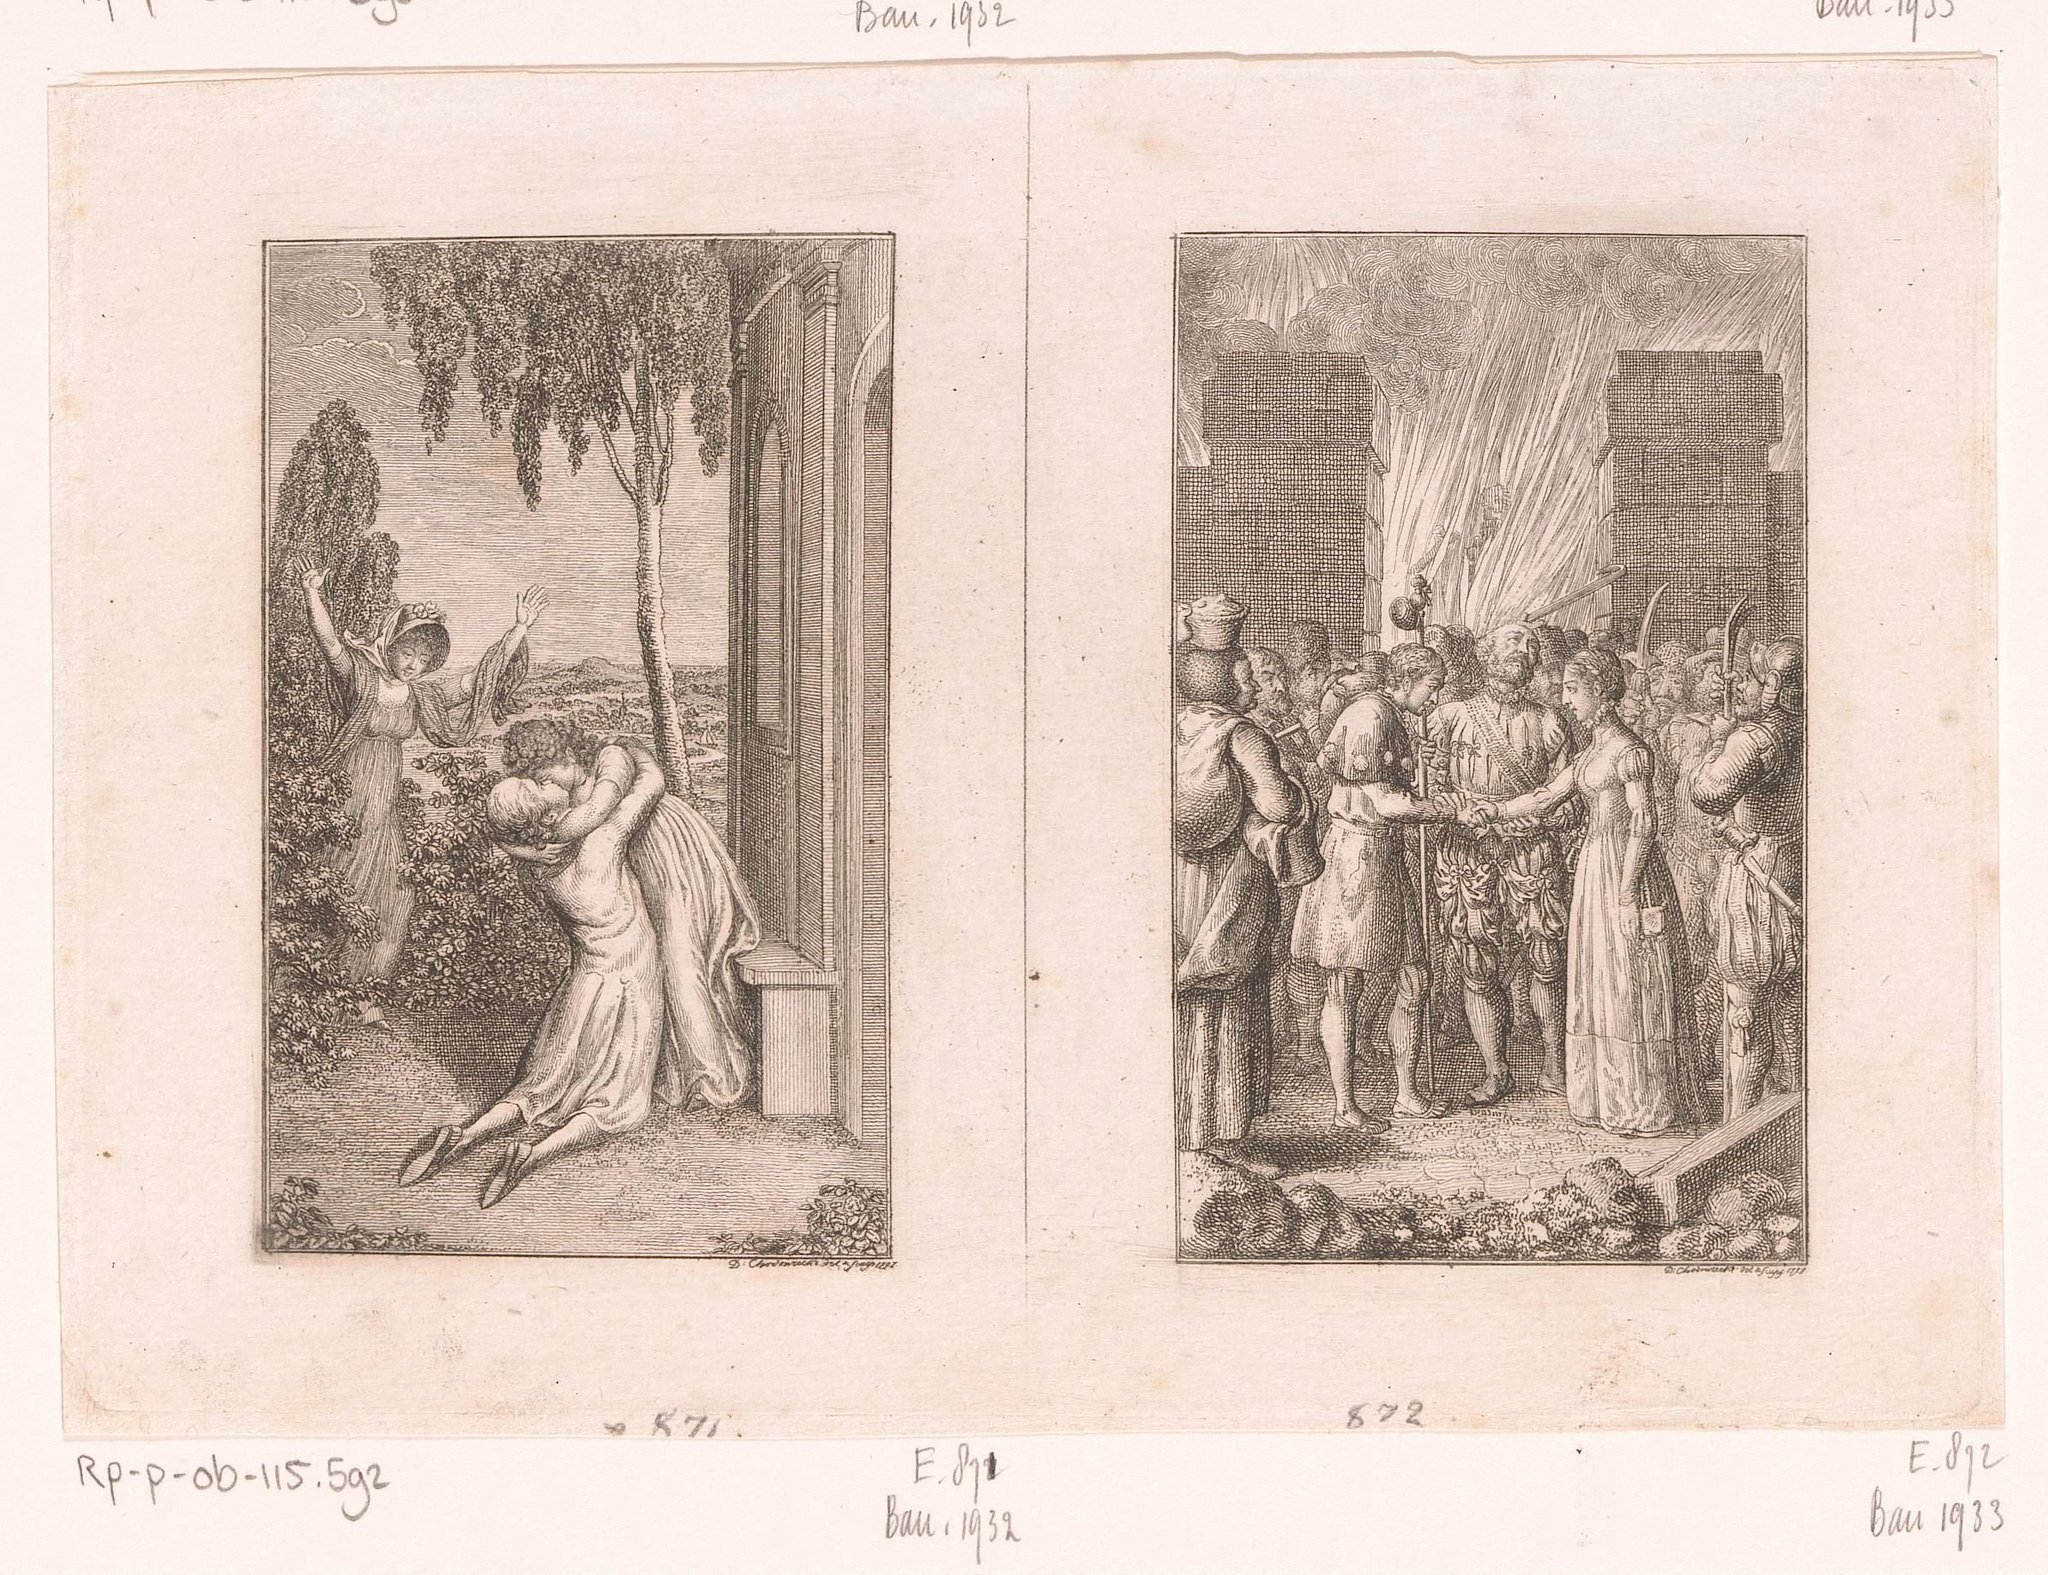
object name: print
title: Twee voorstellingen uit de verhalen van Wilhelm Gottlieb Becker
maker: daniel nikolaus chodowiecki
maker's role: draughtsman, print maker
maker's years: 1726-1801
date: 1797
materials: paper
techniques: etching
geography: berlin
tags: on fire, ablaze, pilgrim(s), kneeling figure, interrupted meeting, lovers caught by surprise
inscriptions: collector's mark: Lugt 2228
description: Latere staat gebruikt voor de verhalen 'Die glückliche Rettung' en 'Adelwold und Emma' in: Becker, Wilhelm Gottlieb. Almanach und Taschenbuch zum geselligen Vergnügen von W. G. Becker für 1799. Leipzig: Voss und Comp., 1798.